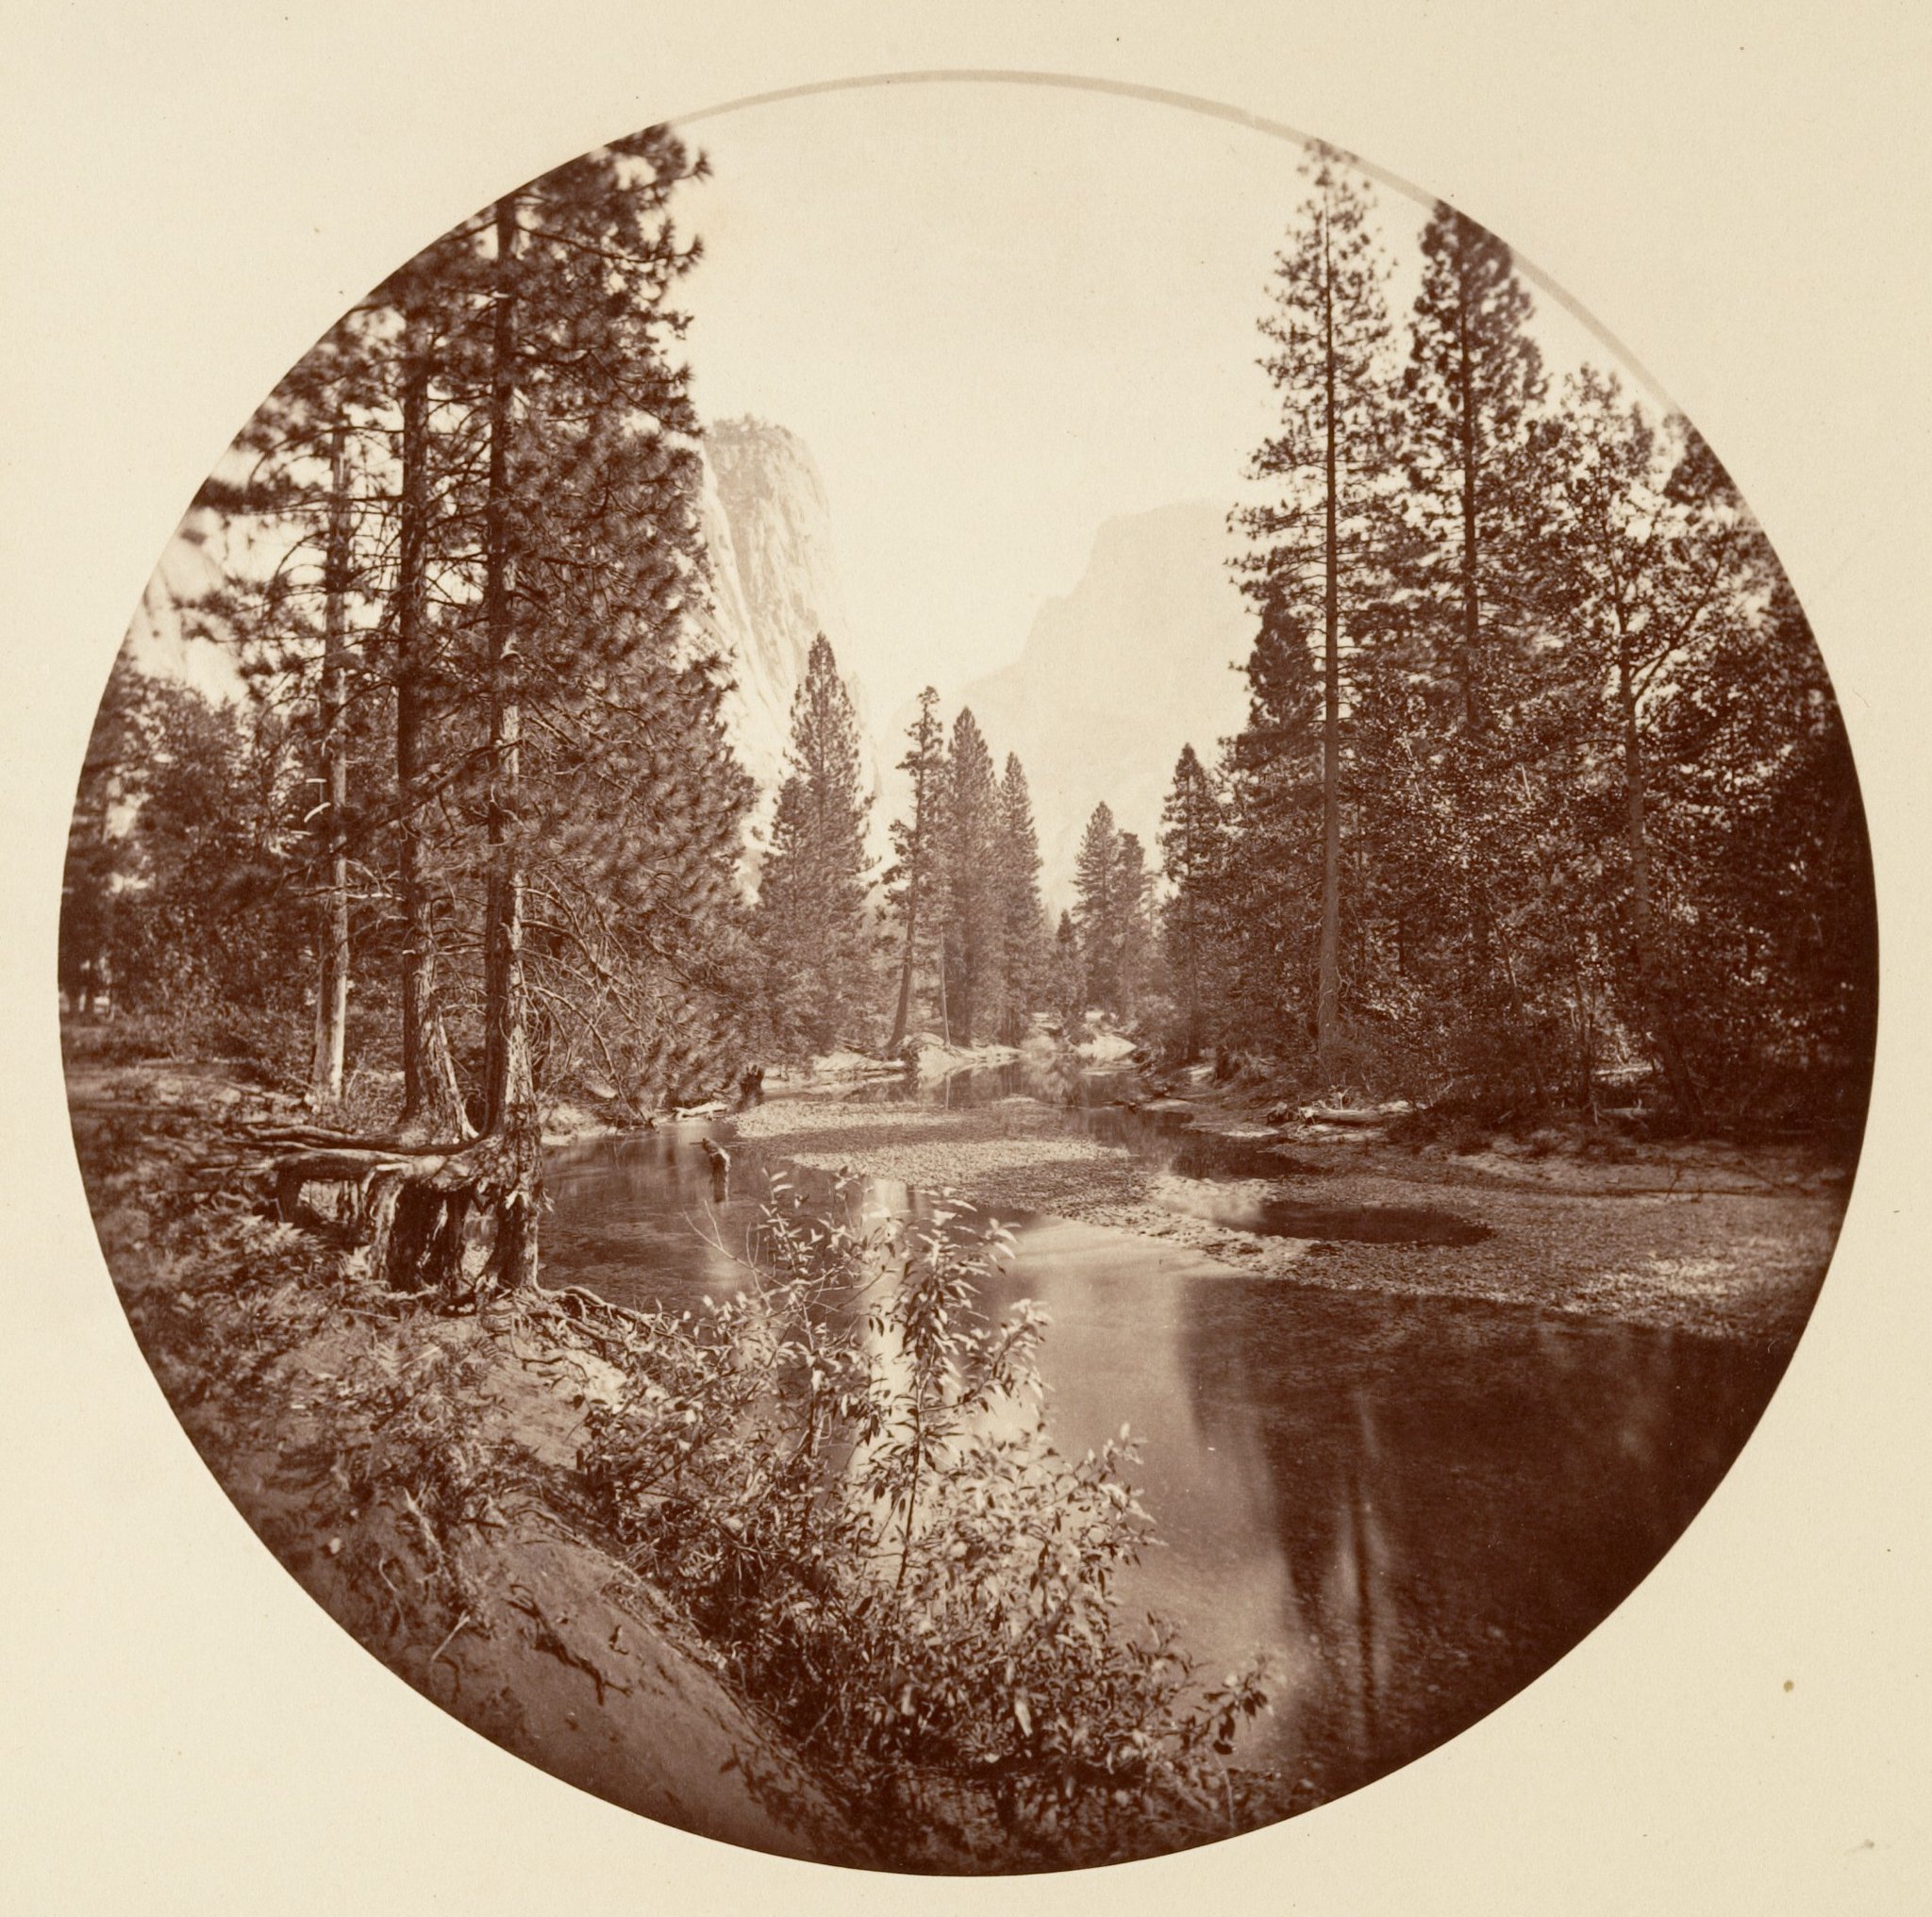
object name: photograph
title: [Yosemite National Park, California]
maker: carleton e. watkins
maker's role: artist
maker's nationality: american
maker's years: 1829-1916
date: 1878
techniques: albumen silver print, glass negative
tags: rivers,landscapes